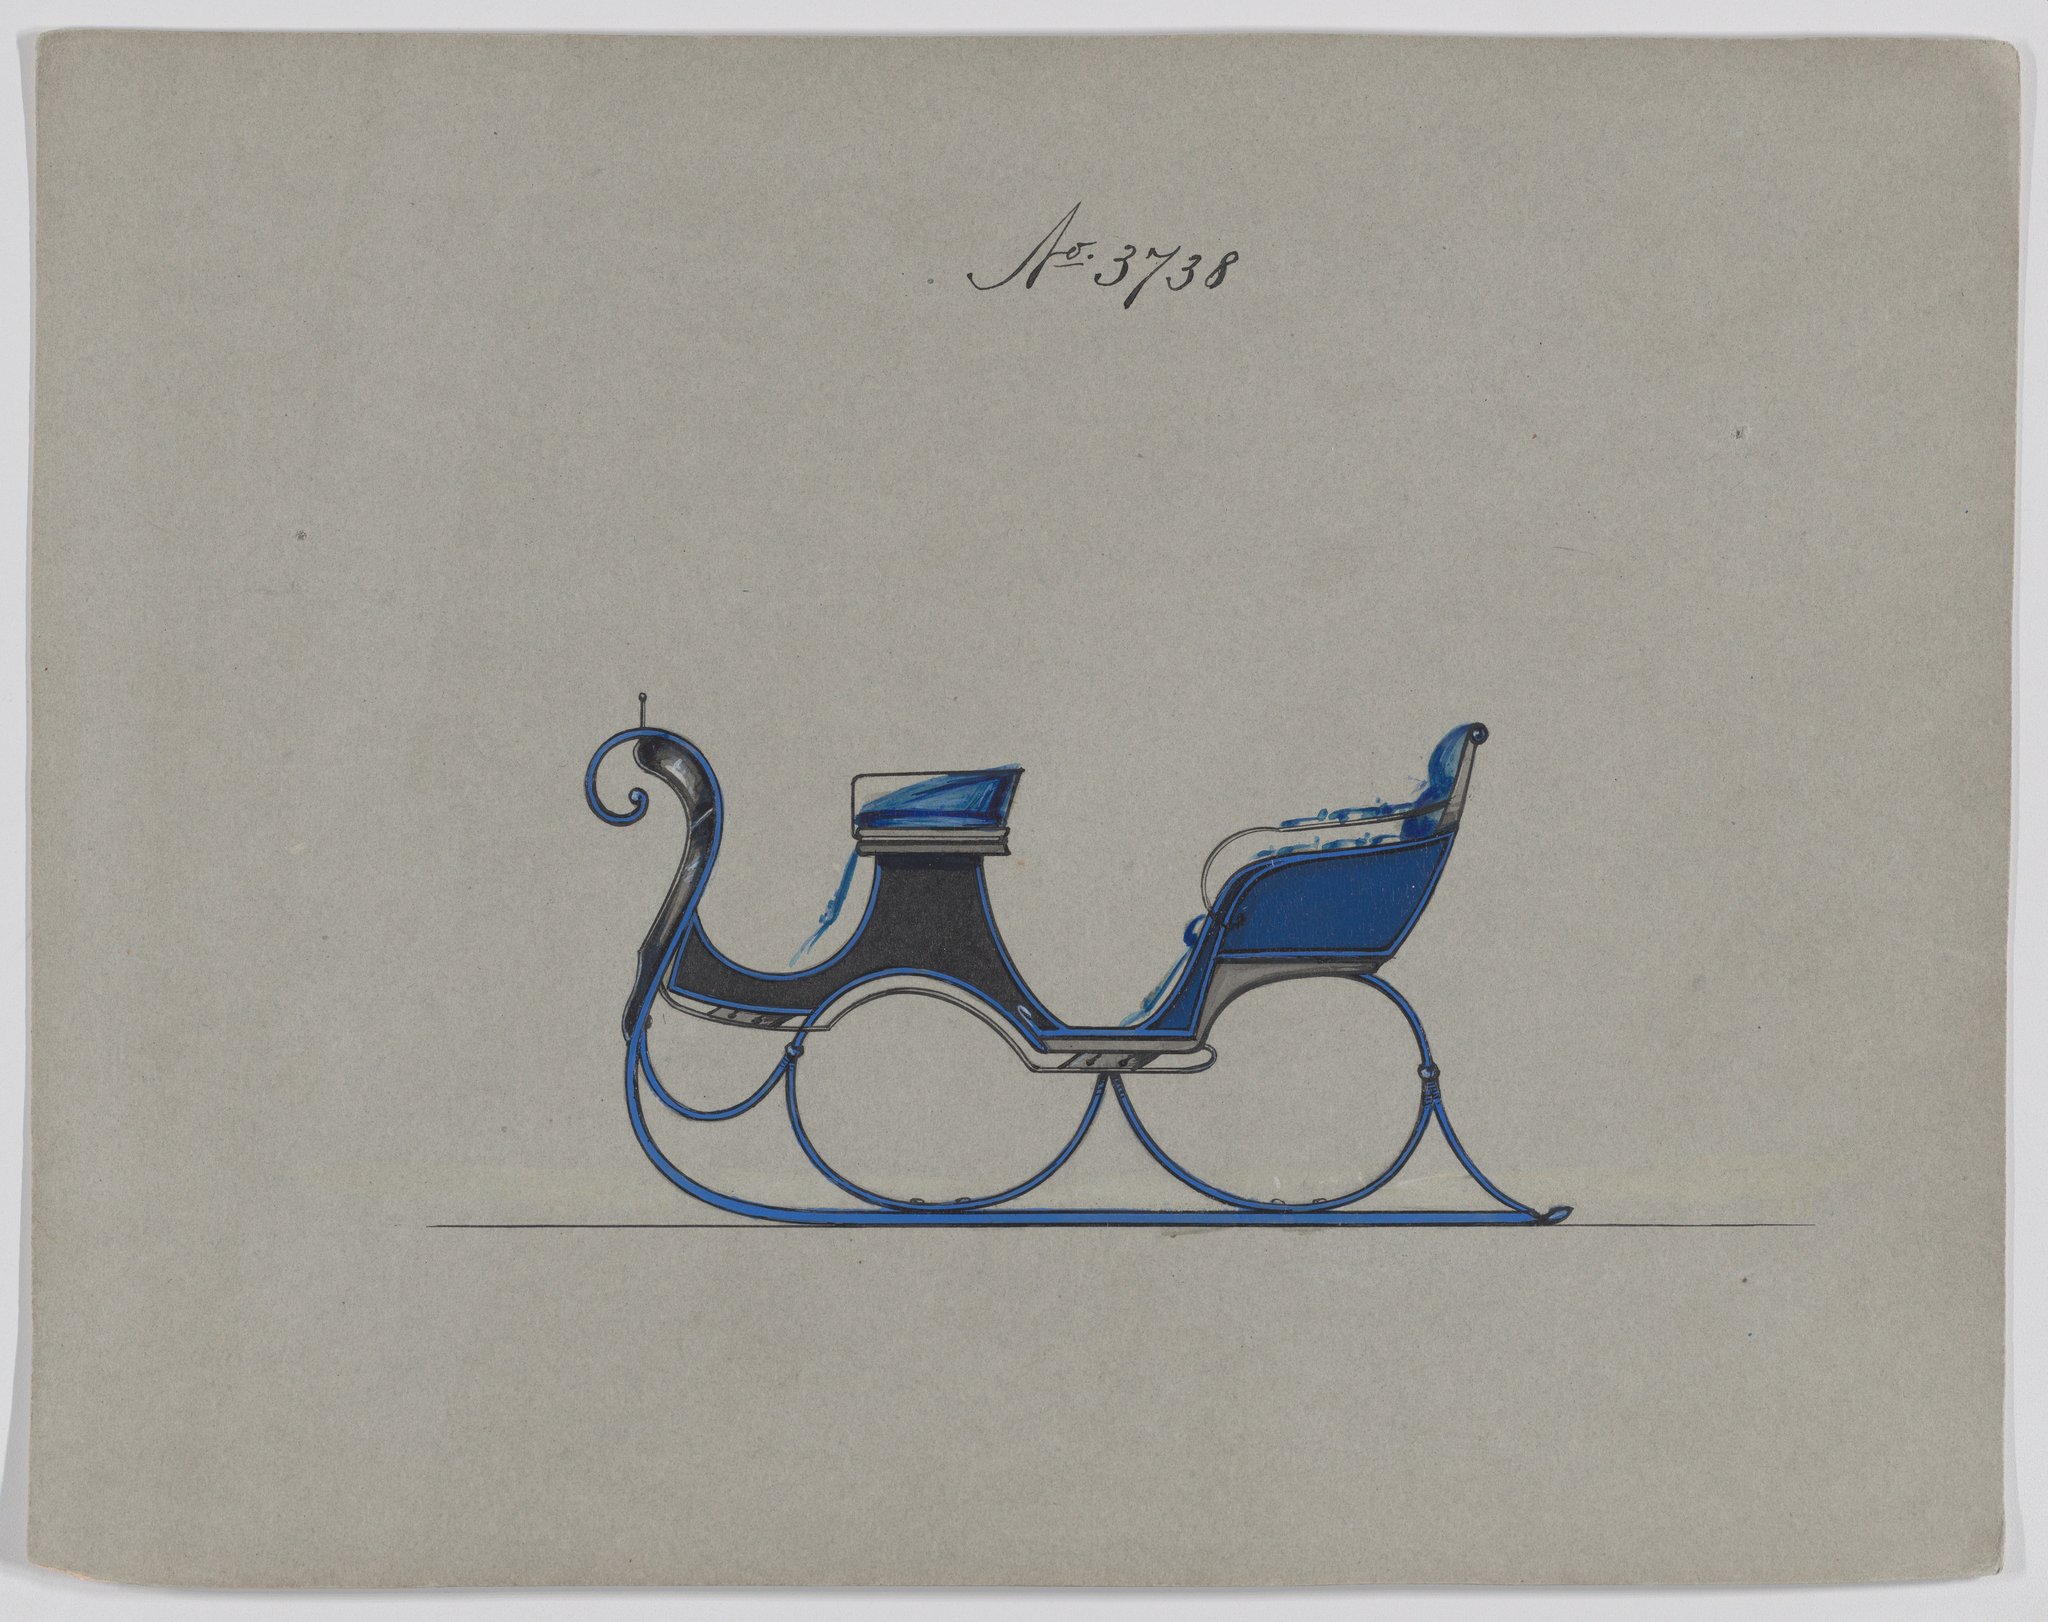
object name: drawing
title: Design for Drop Center Cabriolet Sleigh, no. 3738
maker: brewster & co.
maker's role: manufacturer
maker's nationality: american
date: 1882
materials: gouache, gum arabic, ink, watercolor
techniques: pen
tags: sleighs